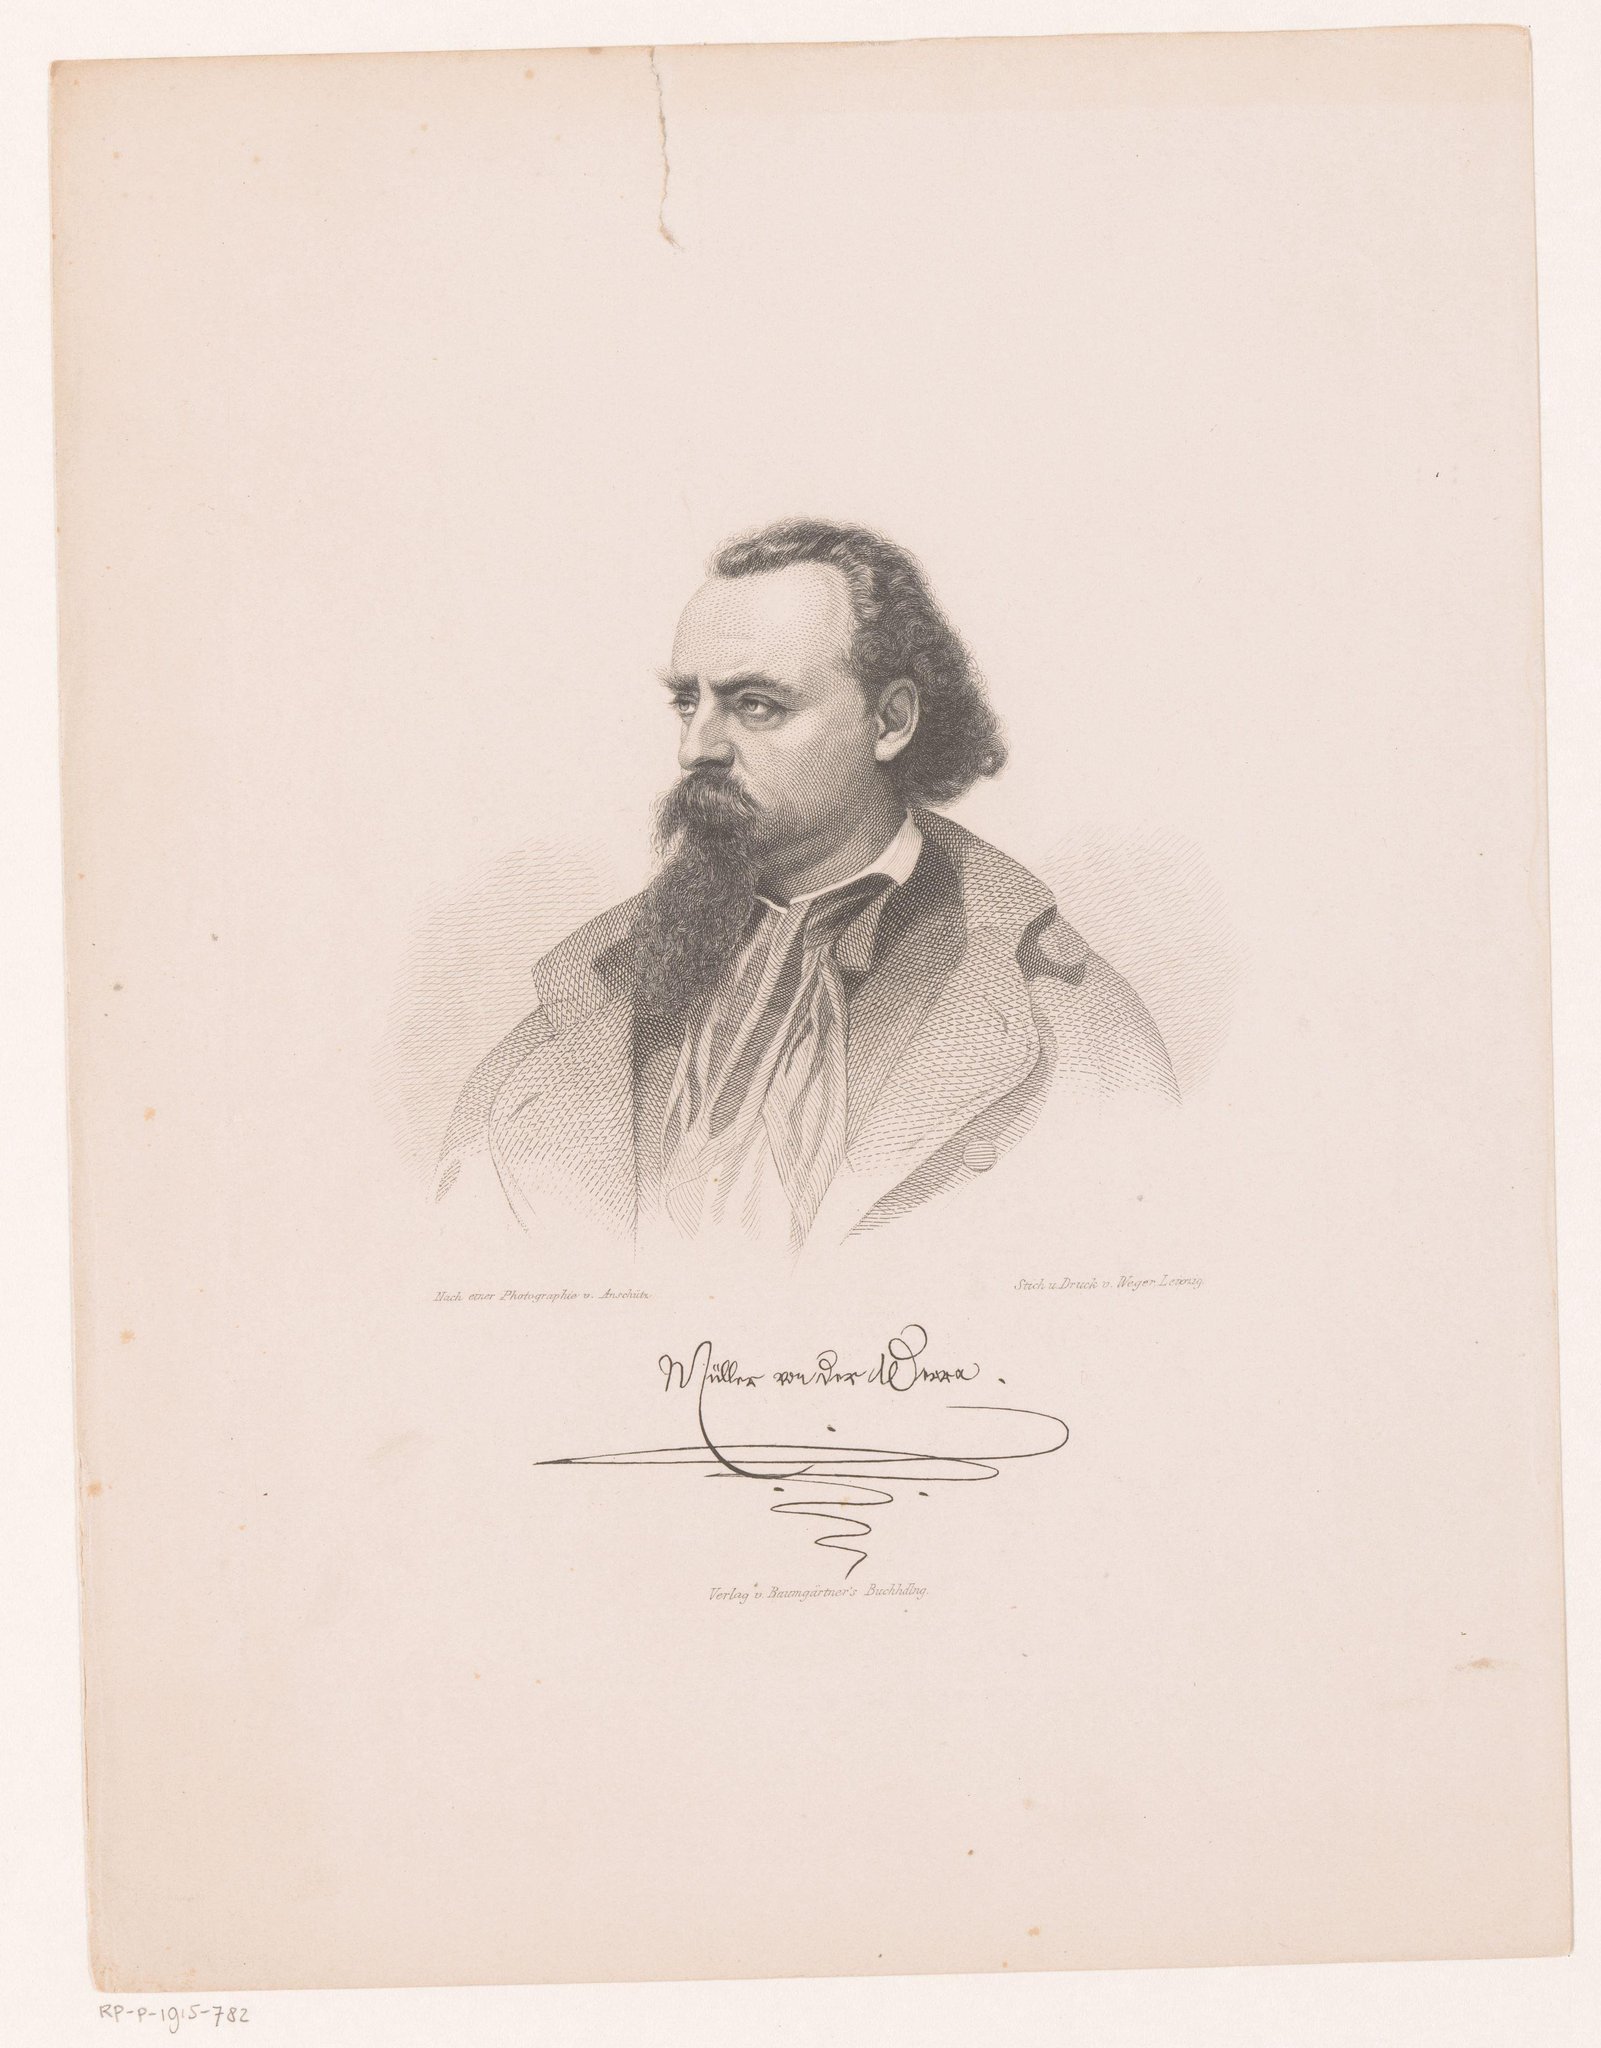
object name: print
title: Portret van Friedrich Konrad Müller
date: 1864-1892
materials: paper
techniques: engraving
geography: leipzig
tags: historical persons, writer, poet, author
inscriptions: collector's mark: Lugt 2228